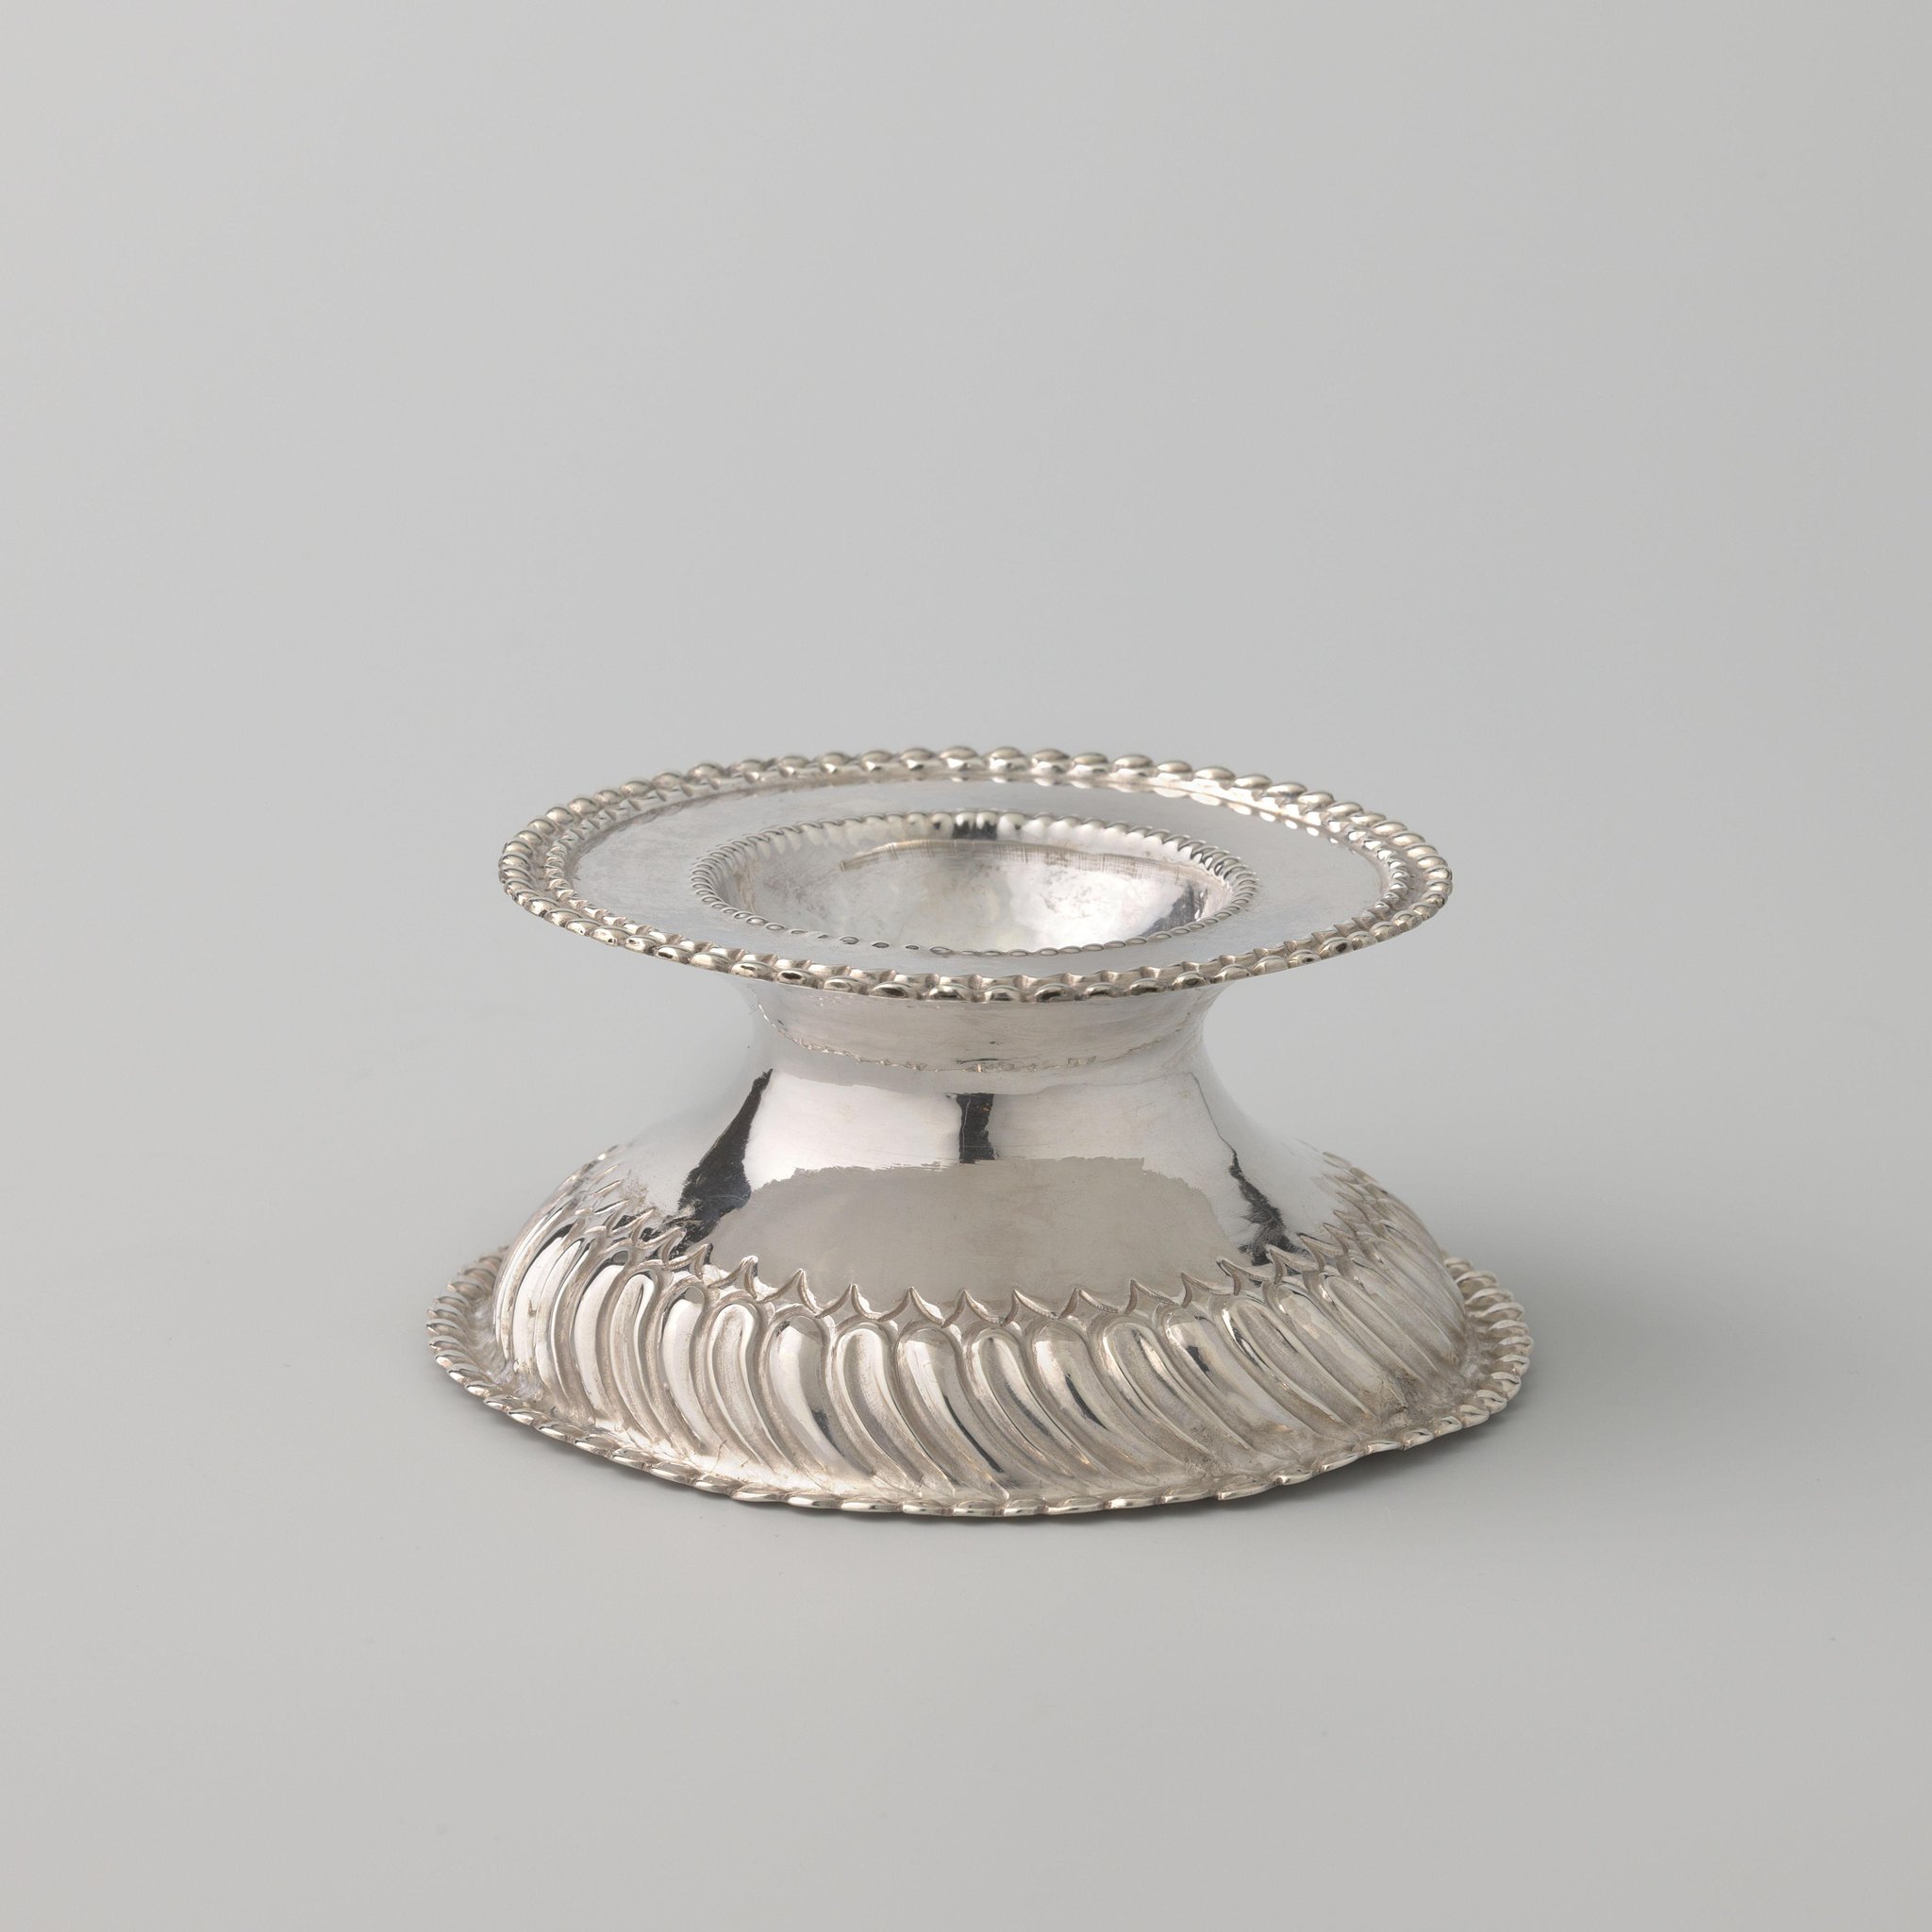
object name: salt condiment vessel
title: Zoutvat van zilver, met hooggewelfde voet, omgeven door een krans van knorren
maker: andries van weggelen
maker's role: silversmith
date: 1728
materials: silver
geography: haarlem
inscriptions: town mark: ‘Hollandse leeuw’, maker's mark: ‘gekroonde W’, : ‘zwaantje in ovaal’, date letter: ‘S in cirkel’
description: Two salt cellars. Silver. Haarlem, 1728 and 1729, by Andries van Weggelen.